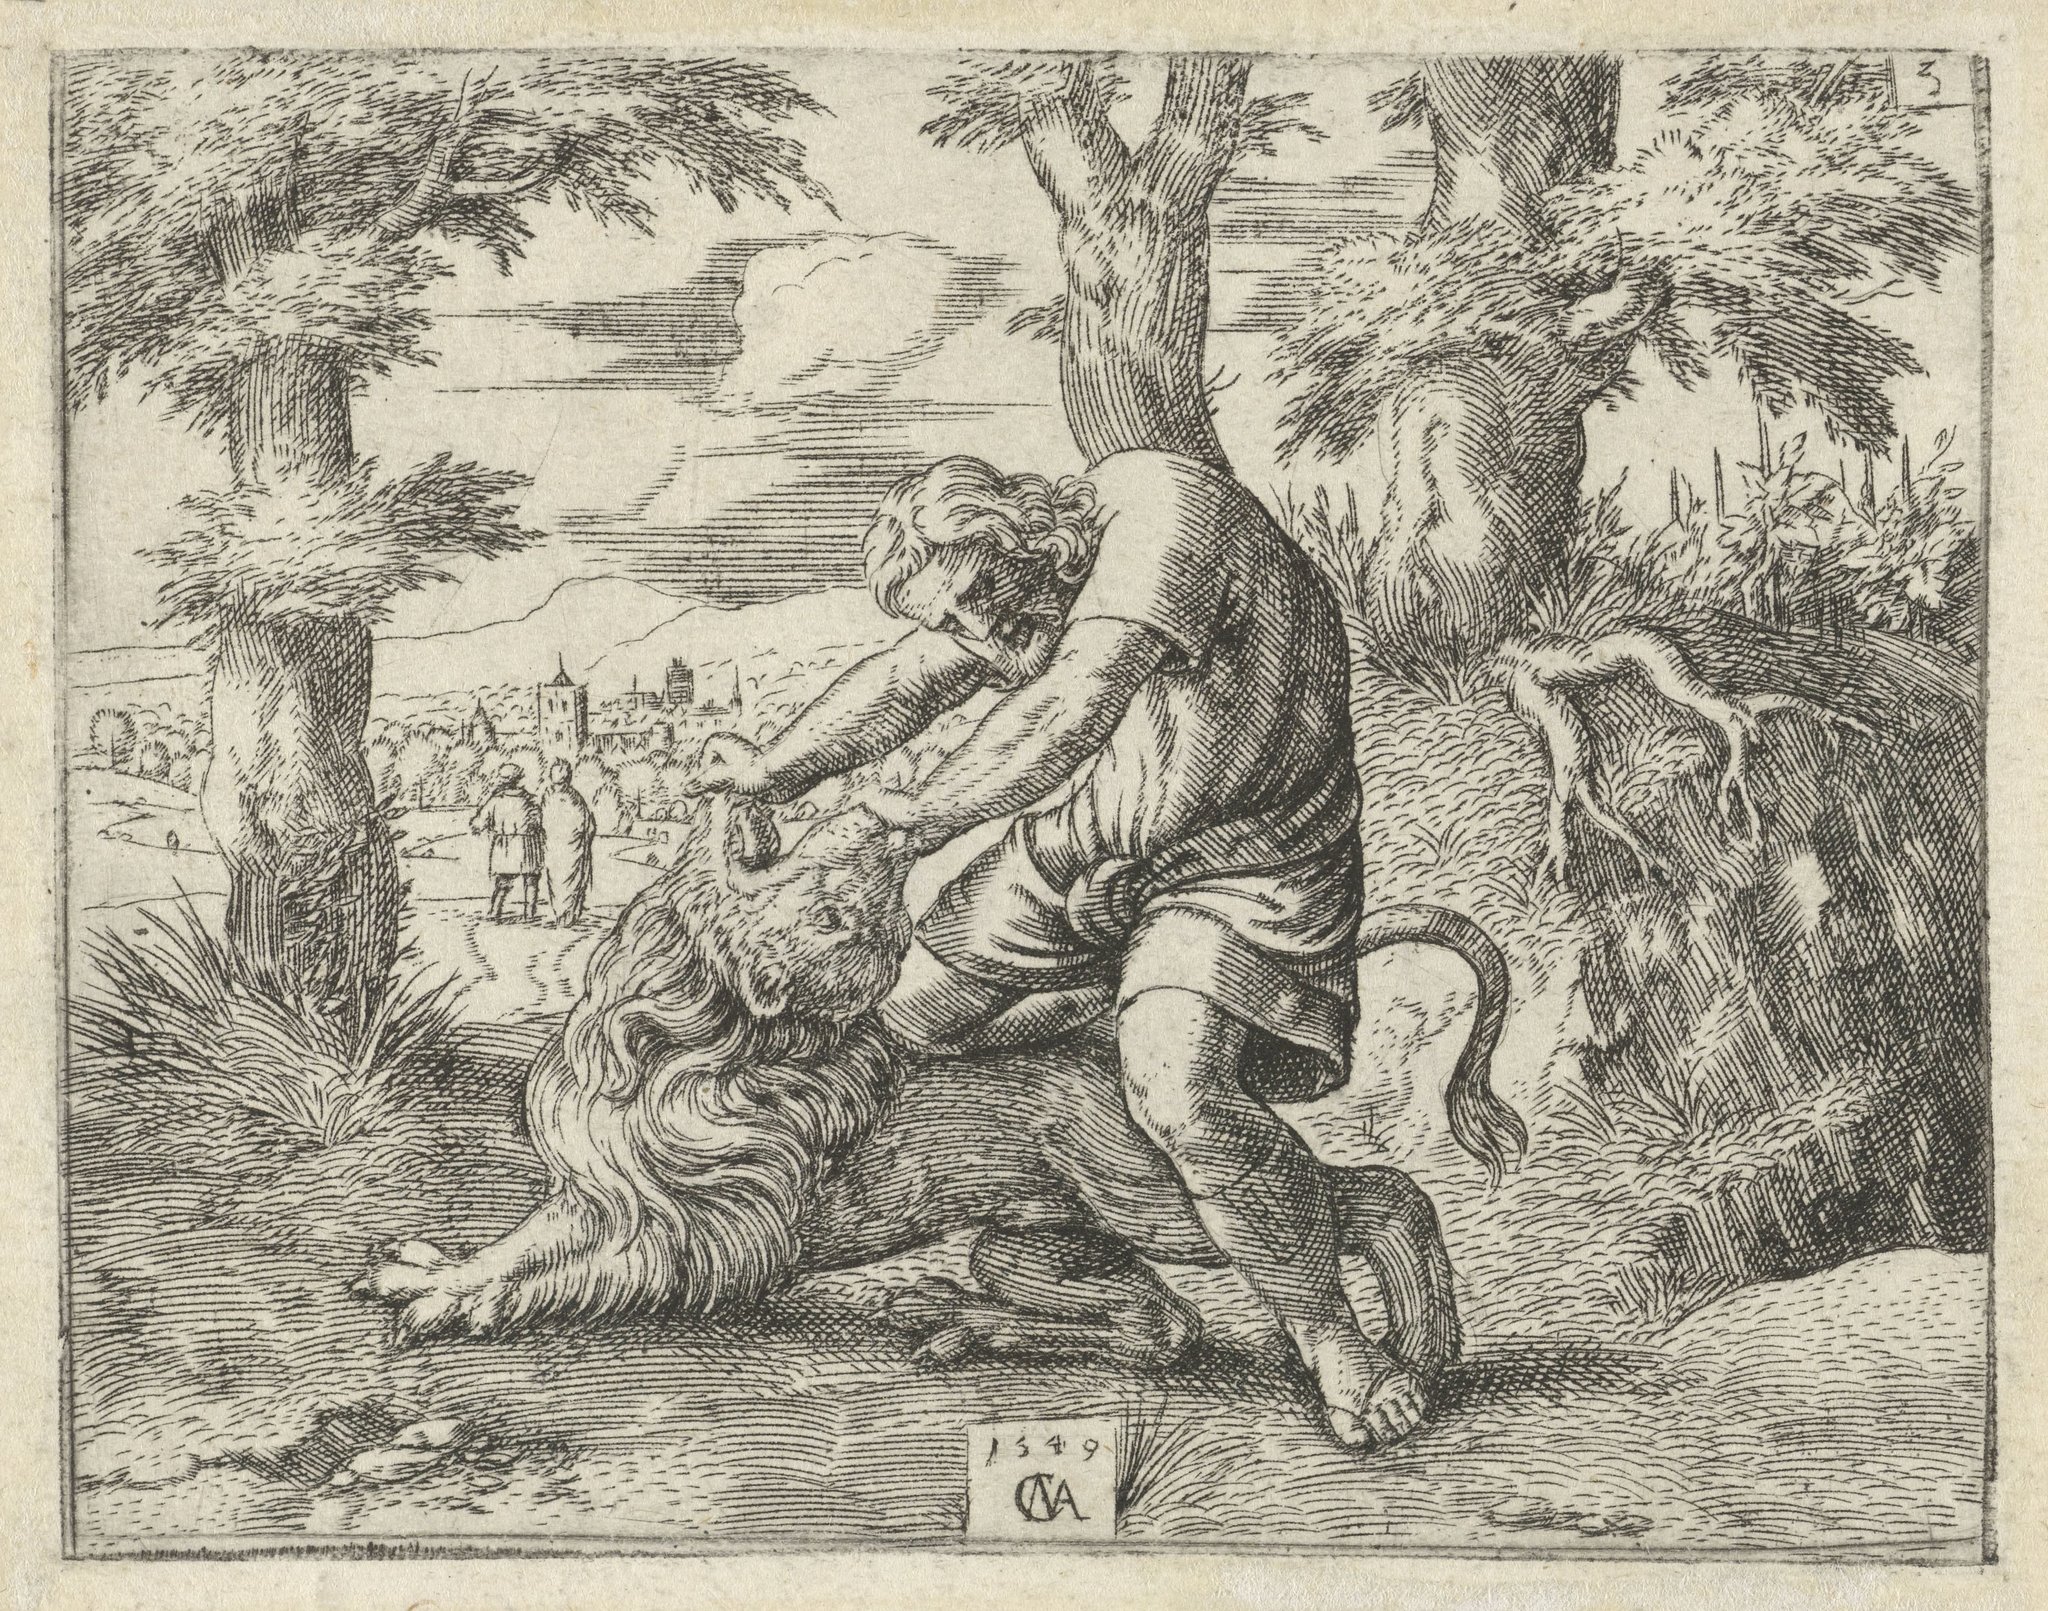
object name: print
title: Simson doodt de leeuw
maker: cornelis massijs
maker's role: painter, print maker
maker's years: 1510-1557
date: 1549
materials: paper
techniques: engraving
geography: antwerp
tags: samson kills the lion with his bare hands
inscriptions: collector's mark: Lugt 2542, collector's mark: Lugt 2228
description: Simson doodt met zijn blote handen de leeuw, door de kaken van het dier uiteen te trekken. Op de achtergrond een landschap met twee figuren en een stad.